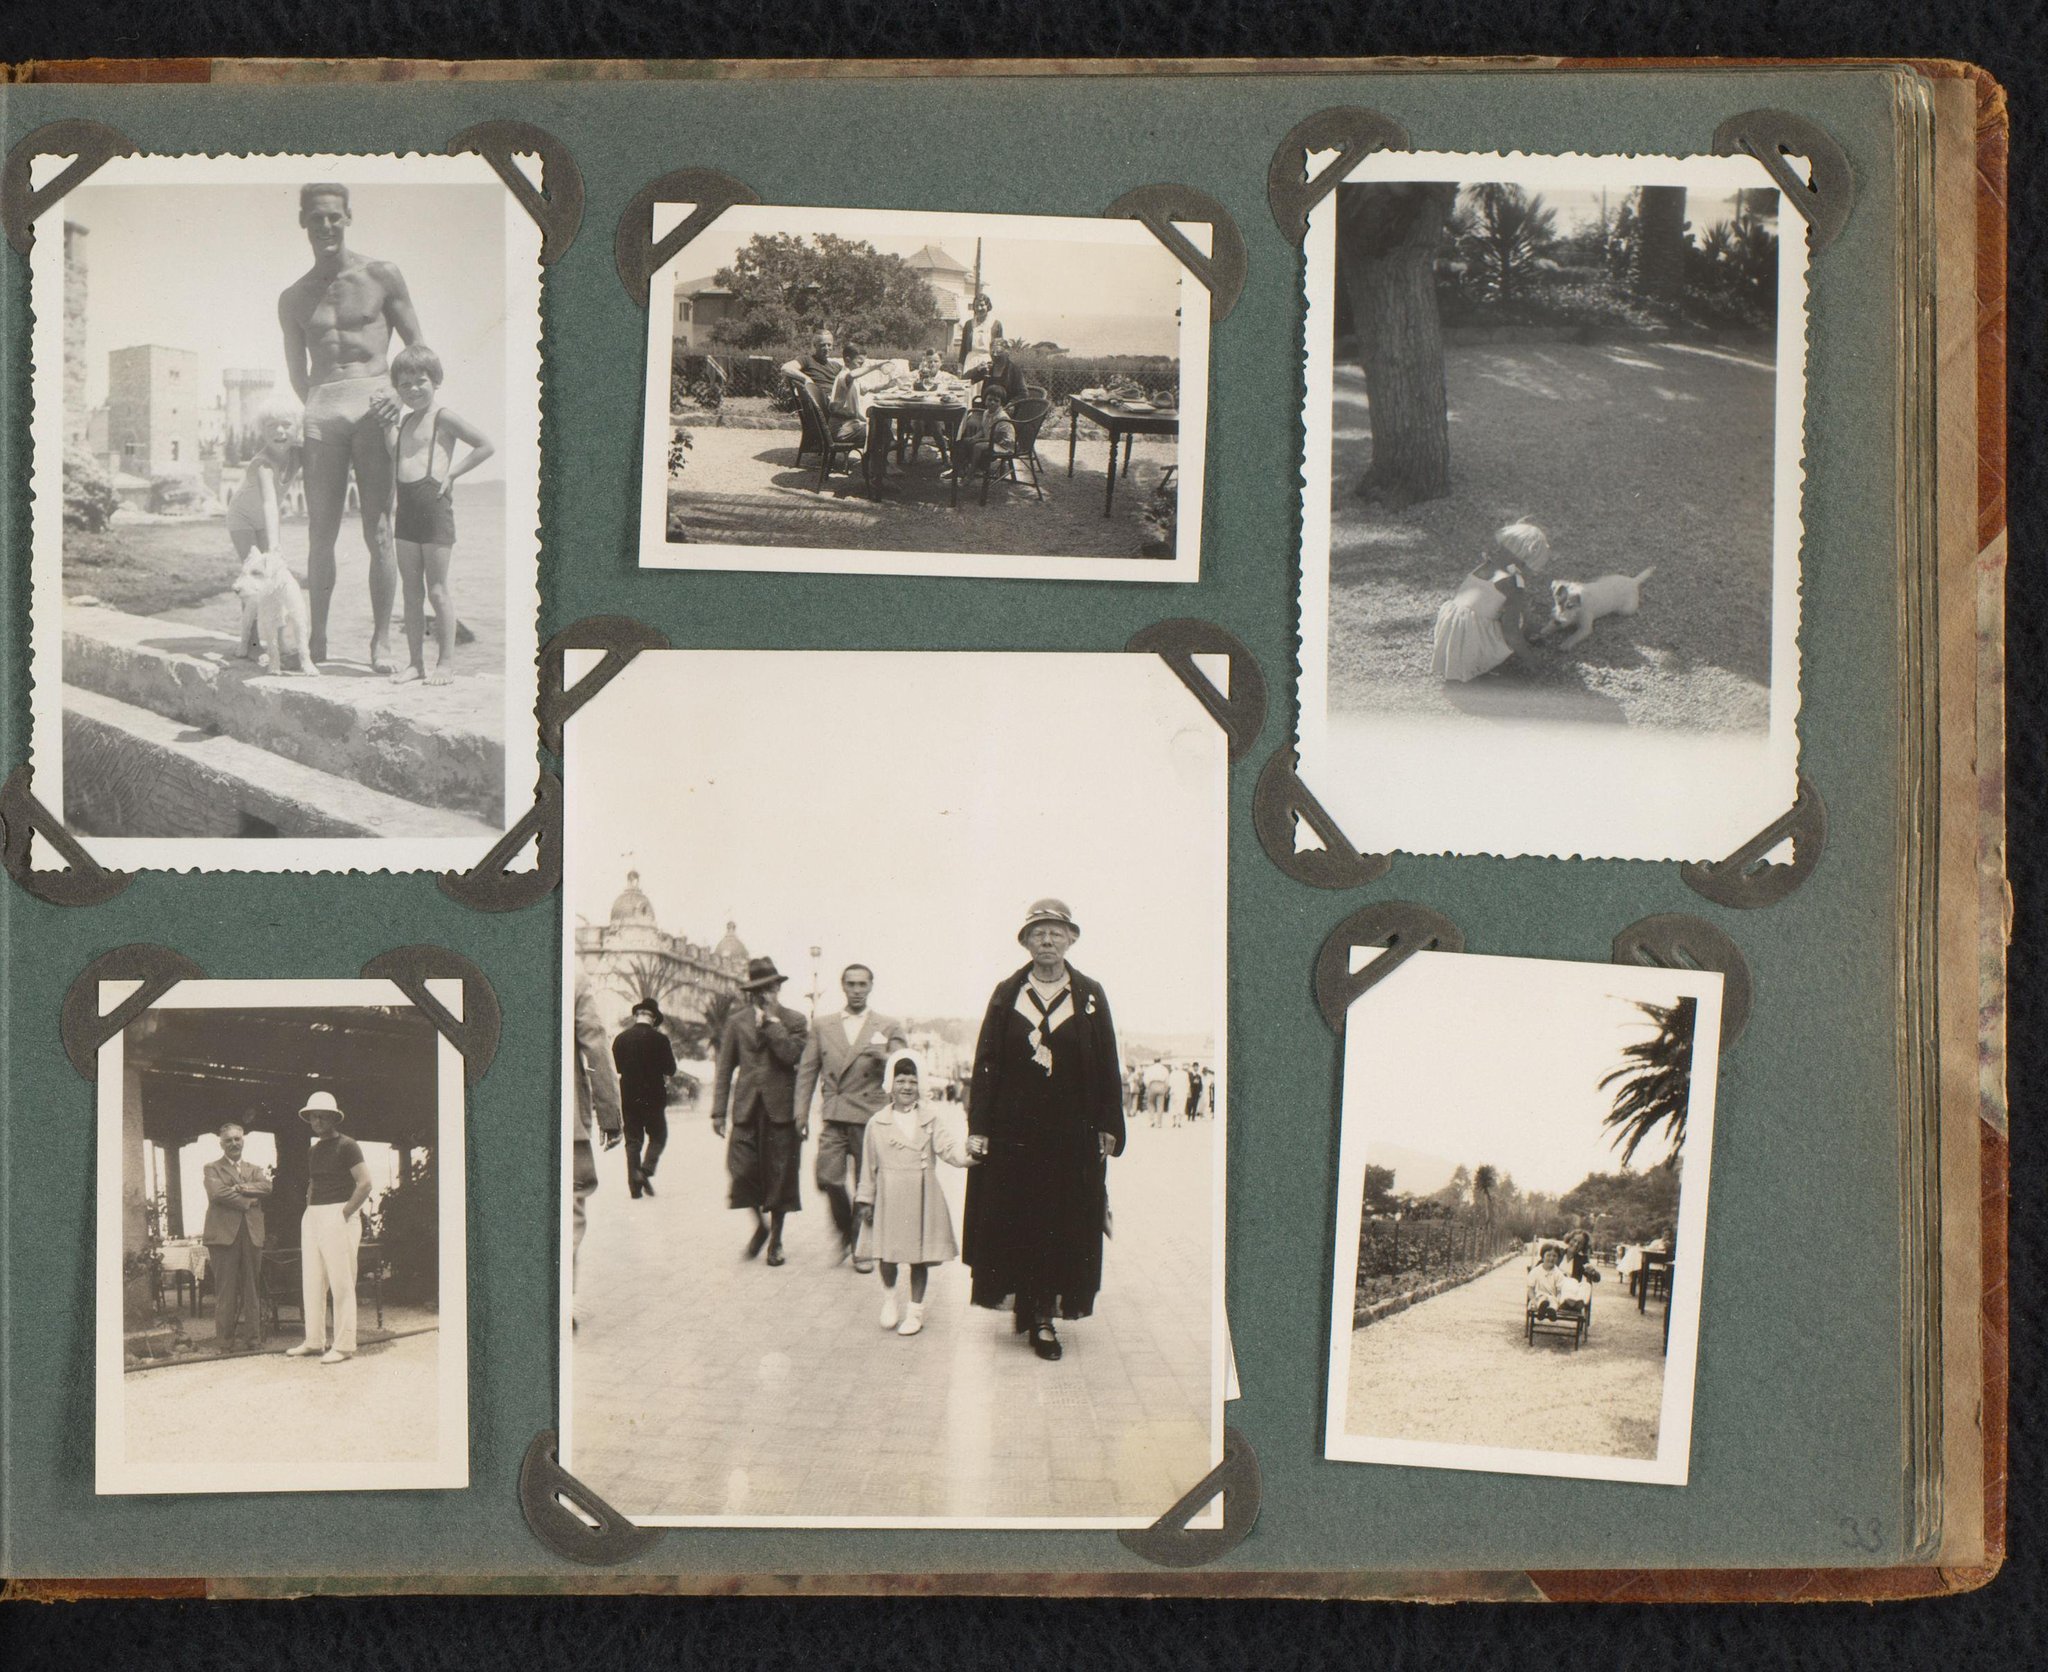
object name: album leaf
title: Zes foto's van familie Onnen-Van den Berg aan de Côte d'Azur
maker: Anonymous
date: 1920-1930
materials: paper, cardboard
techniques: gelatin silver print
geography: côte d'azur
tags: beach (as place of recreation), the family travelling, on holiday, castle, avenue, boulevard, promenade, esplanade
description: Deze foto's maken deel uit van een album.